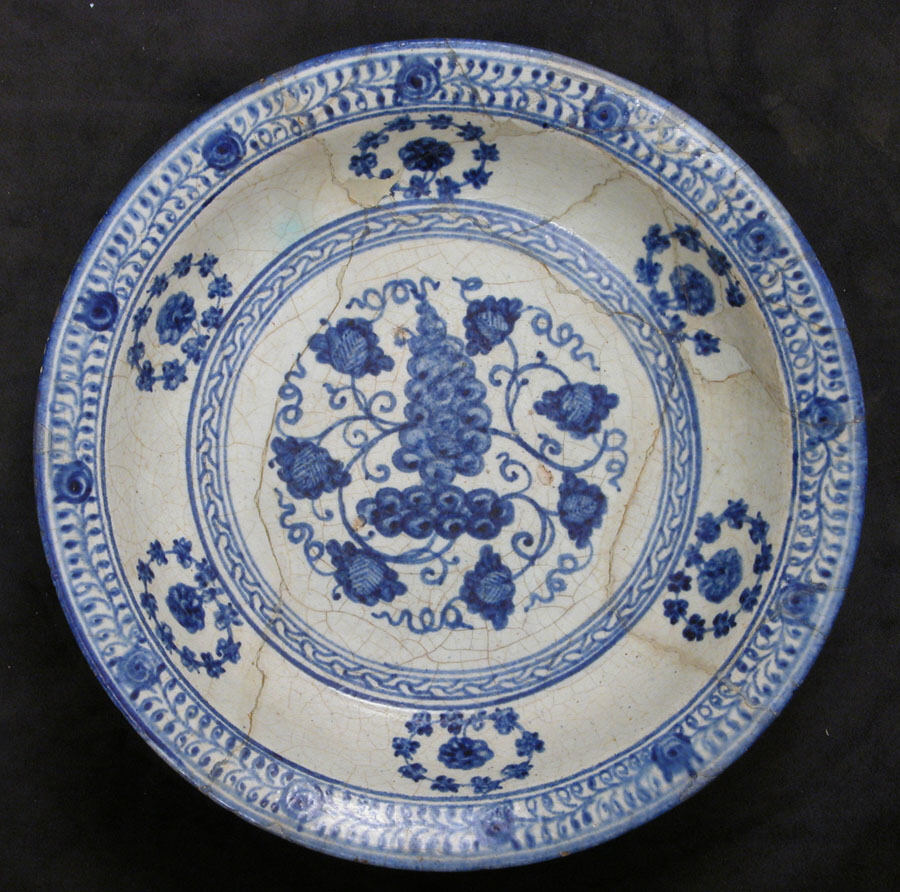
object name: dish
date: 1601-1700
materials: stonepaste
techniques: painting, underglaze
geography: turkey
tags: grapes,flowers